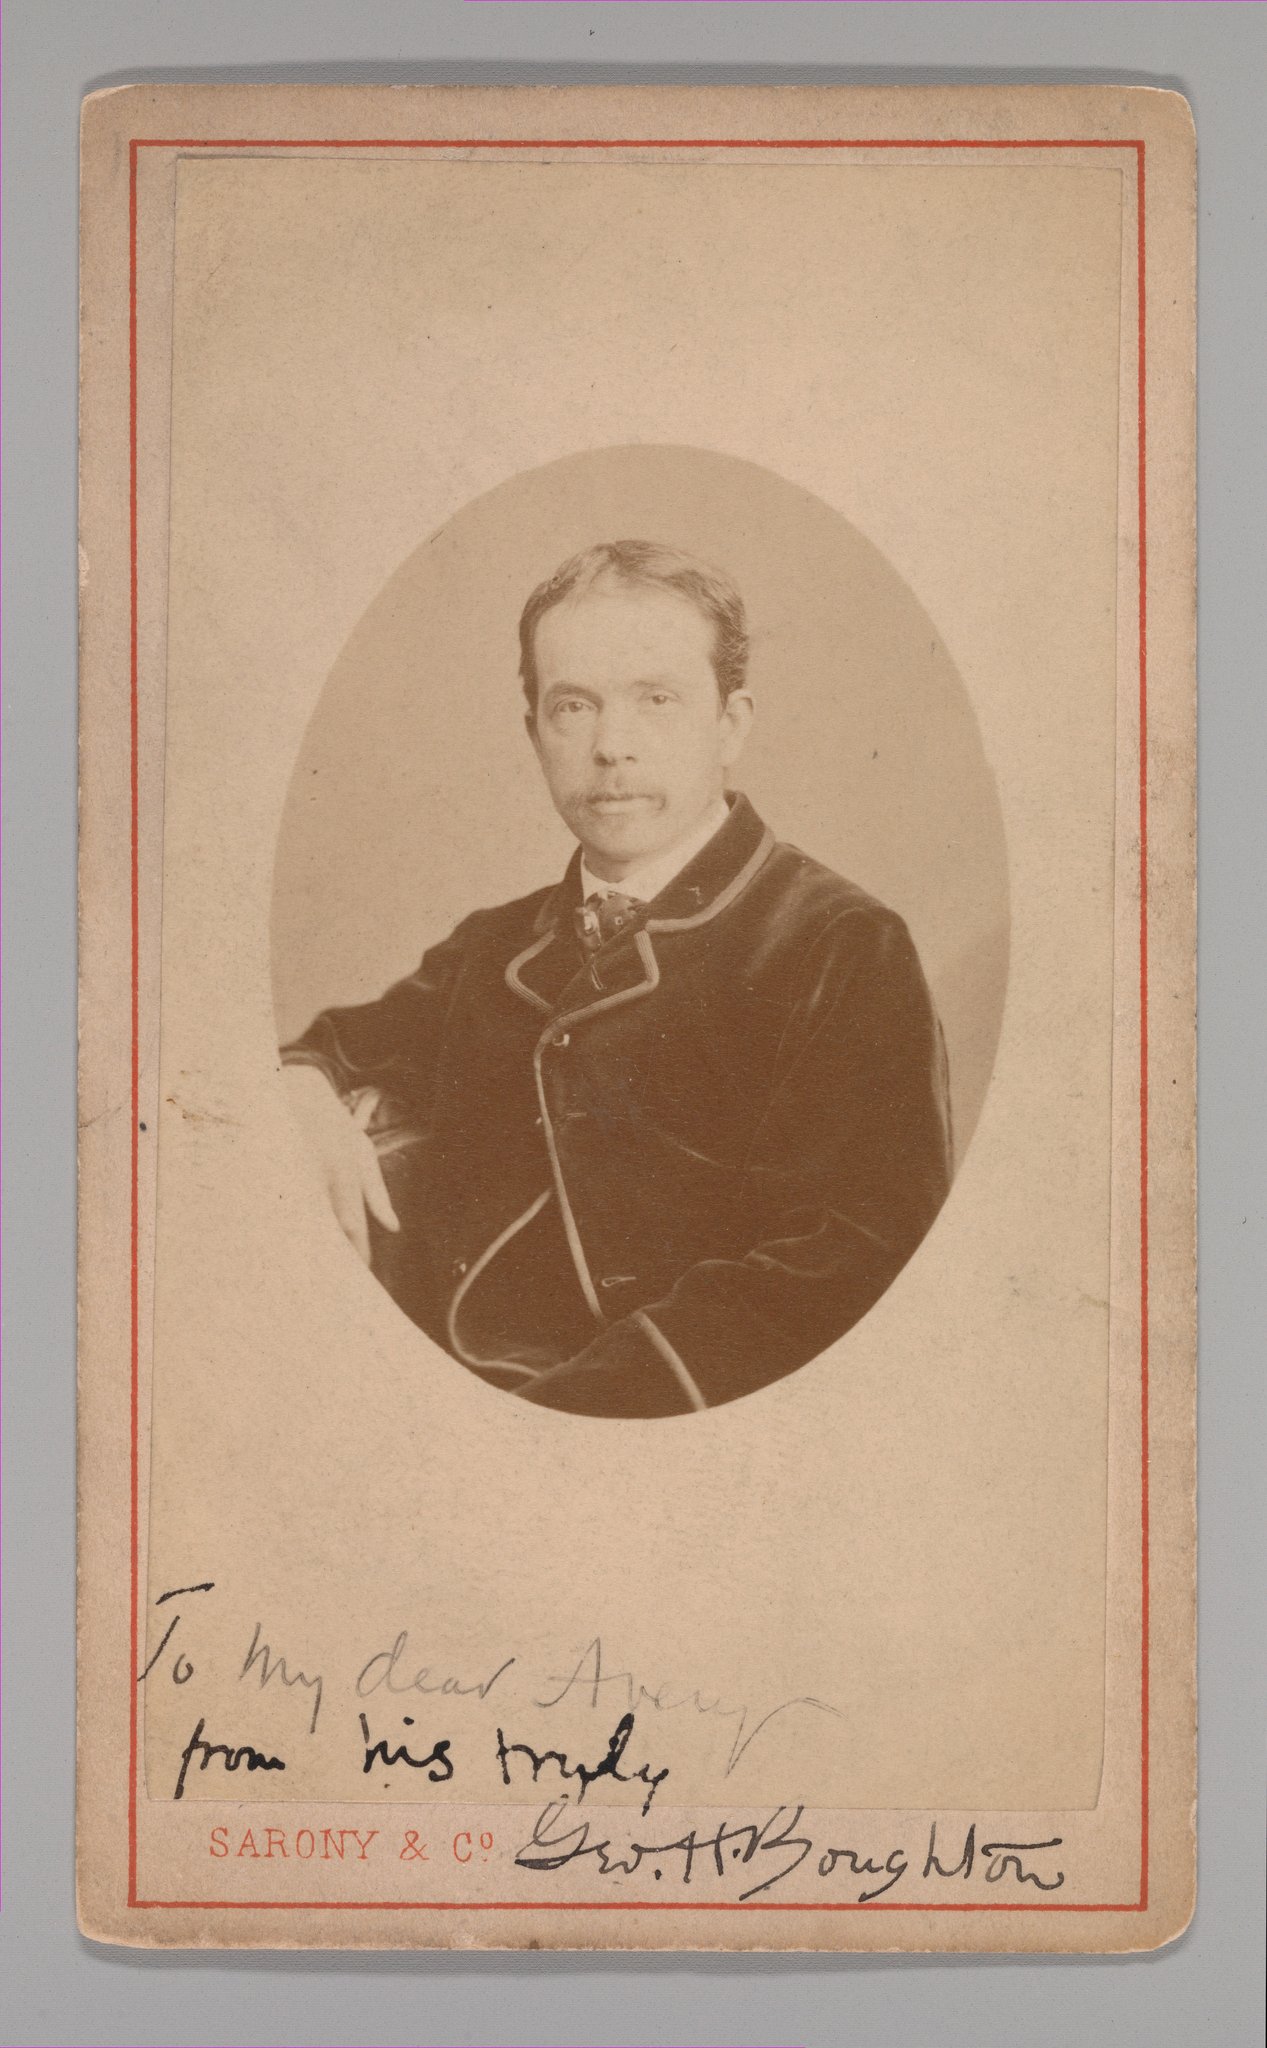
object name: carte de visite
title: [George Henry Boughton]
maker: oliver françois xavier sarony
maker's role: artist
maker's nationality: canadian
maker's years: 1820-1879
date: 1860-1869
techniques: albumen silver print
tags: men,portraits